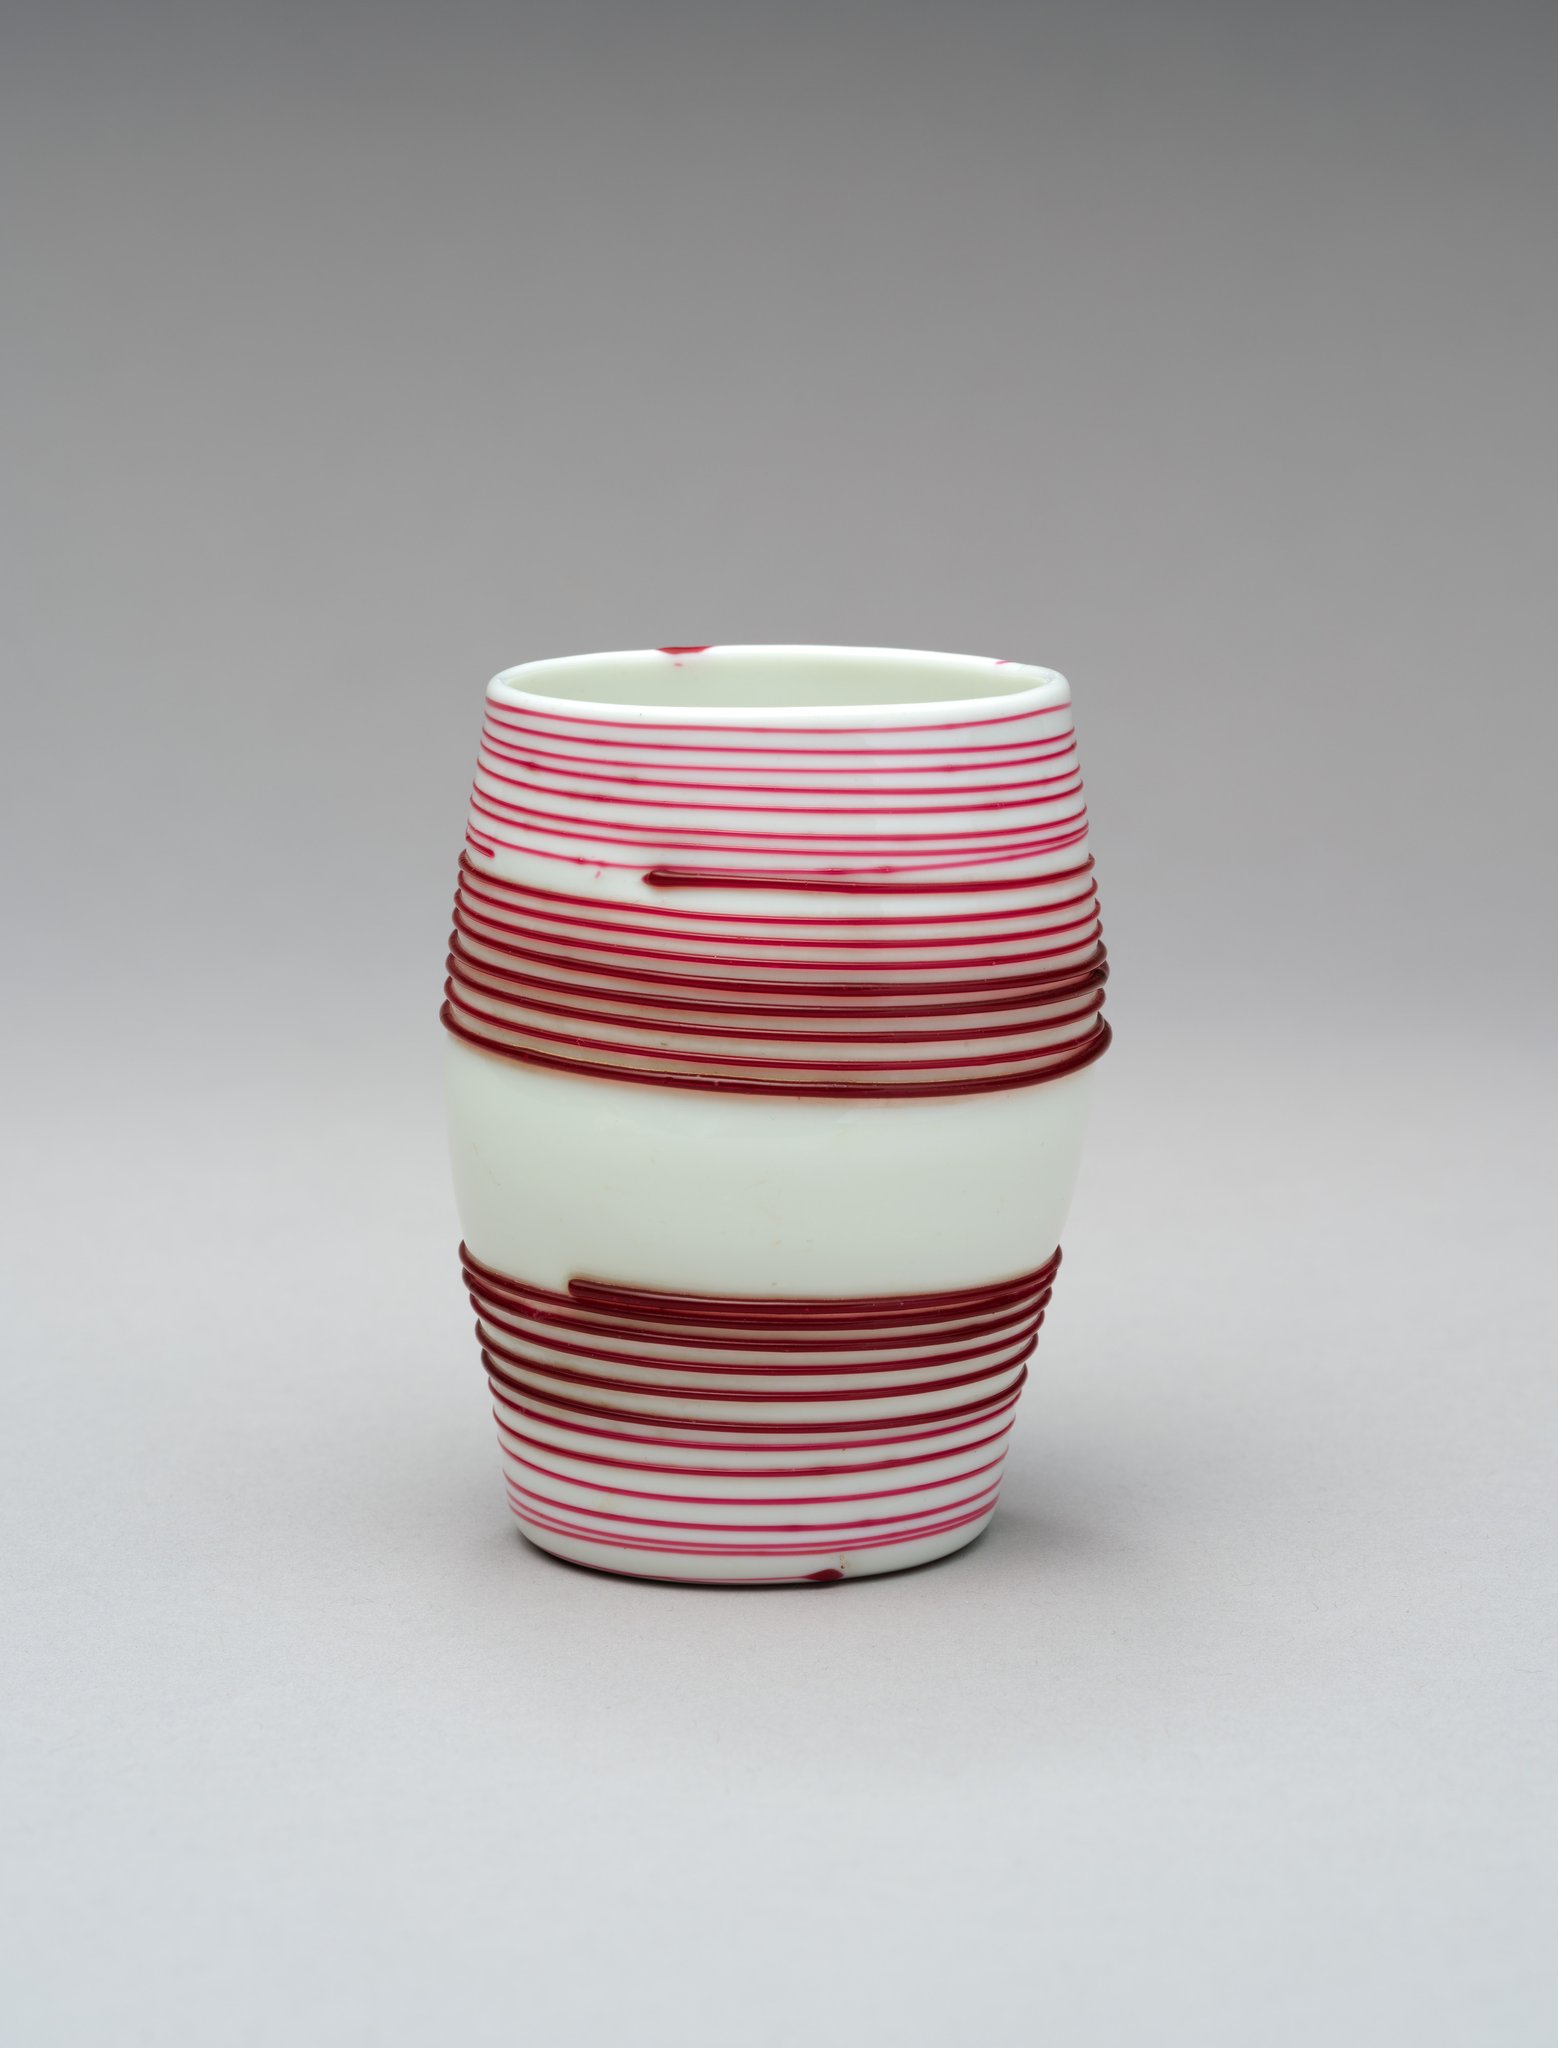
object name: beaker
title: White beaker decorated with red lines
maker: glasshouse of bernard perrot, verrerie royale d'orléans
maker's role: maker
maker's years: 1640-1709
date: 1701-1800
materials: glass